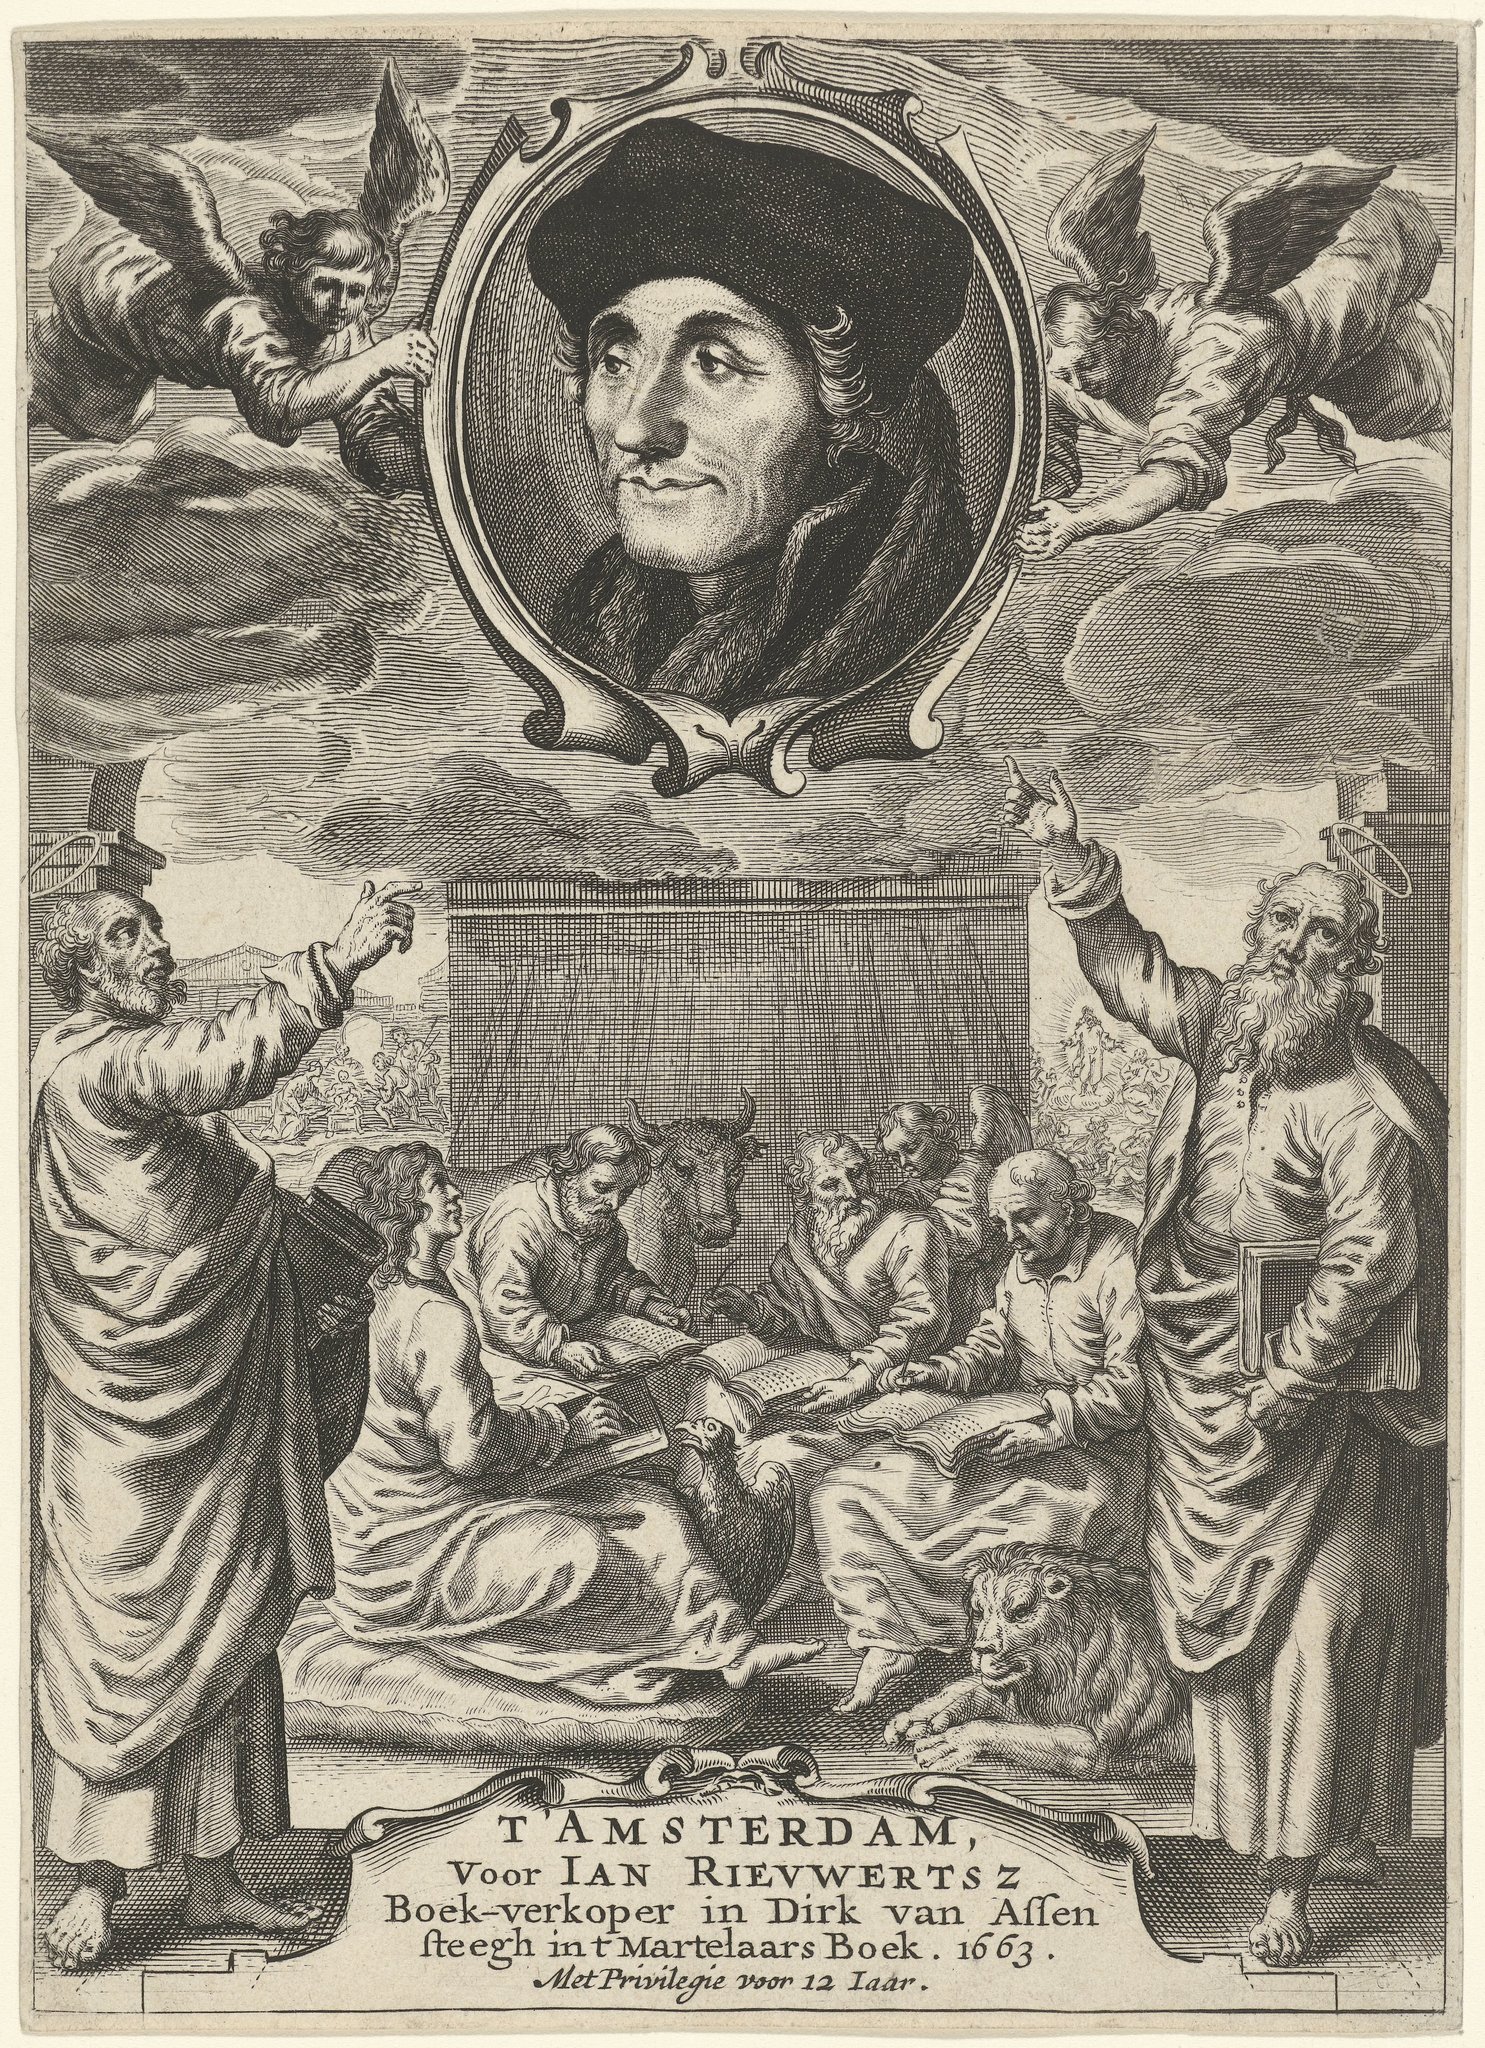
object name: print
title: Titelpagina voor: Erasmus, Annotationes, 1663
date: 1663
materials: paper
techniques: engraving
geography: amsterdam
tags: rotterdam, desiderius erasmus, the evangelists writing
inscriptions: collector's mark: Lugt 2228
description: De vier evangelisten met hun symbolen mens, leeuw, adelaar en os, terwijl zij schrijven. Op de voorgrond aan weerszijden twee mannenfiguren met aureool die naar boven wijzen, naar het portret van Desiderius Erasmus, dat wordt vastgehouden door twee engelen.